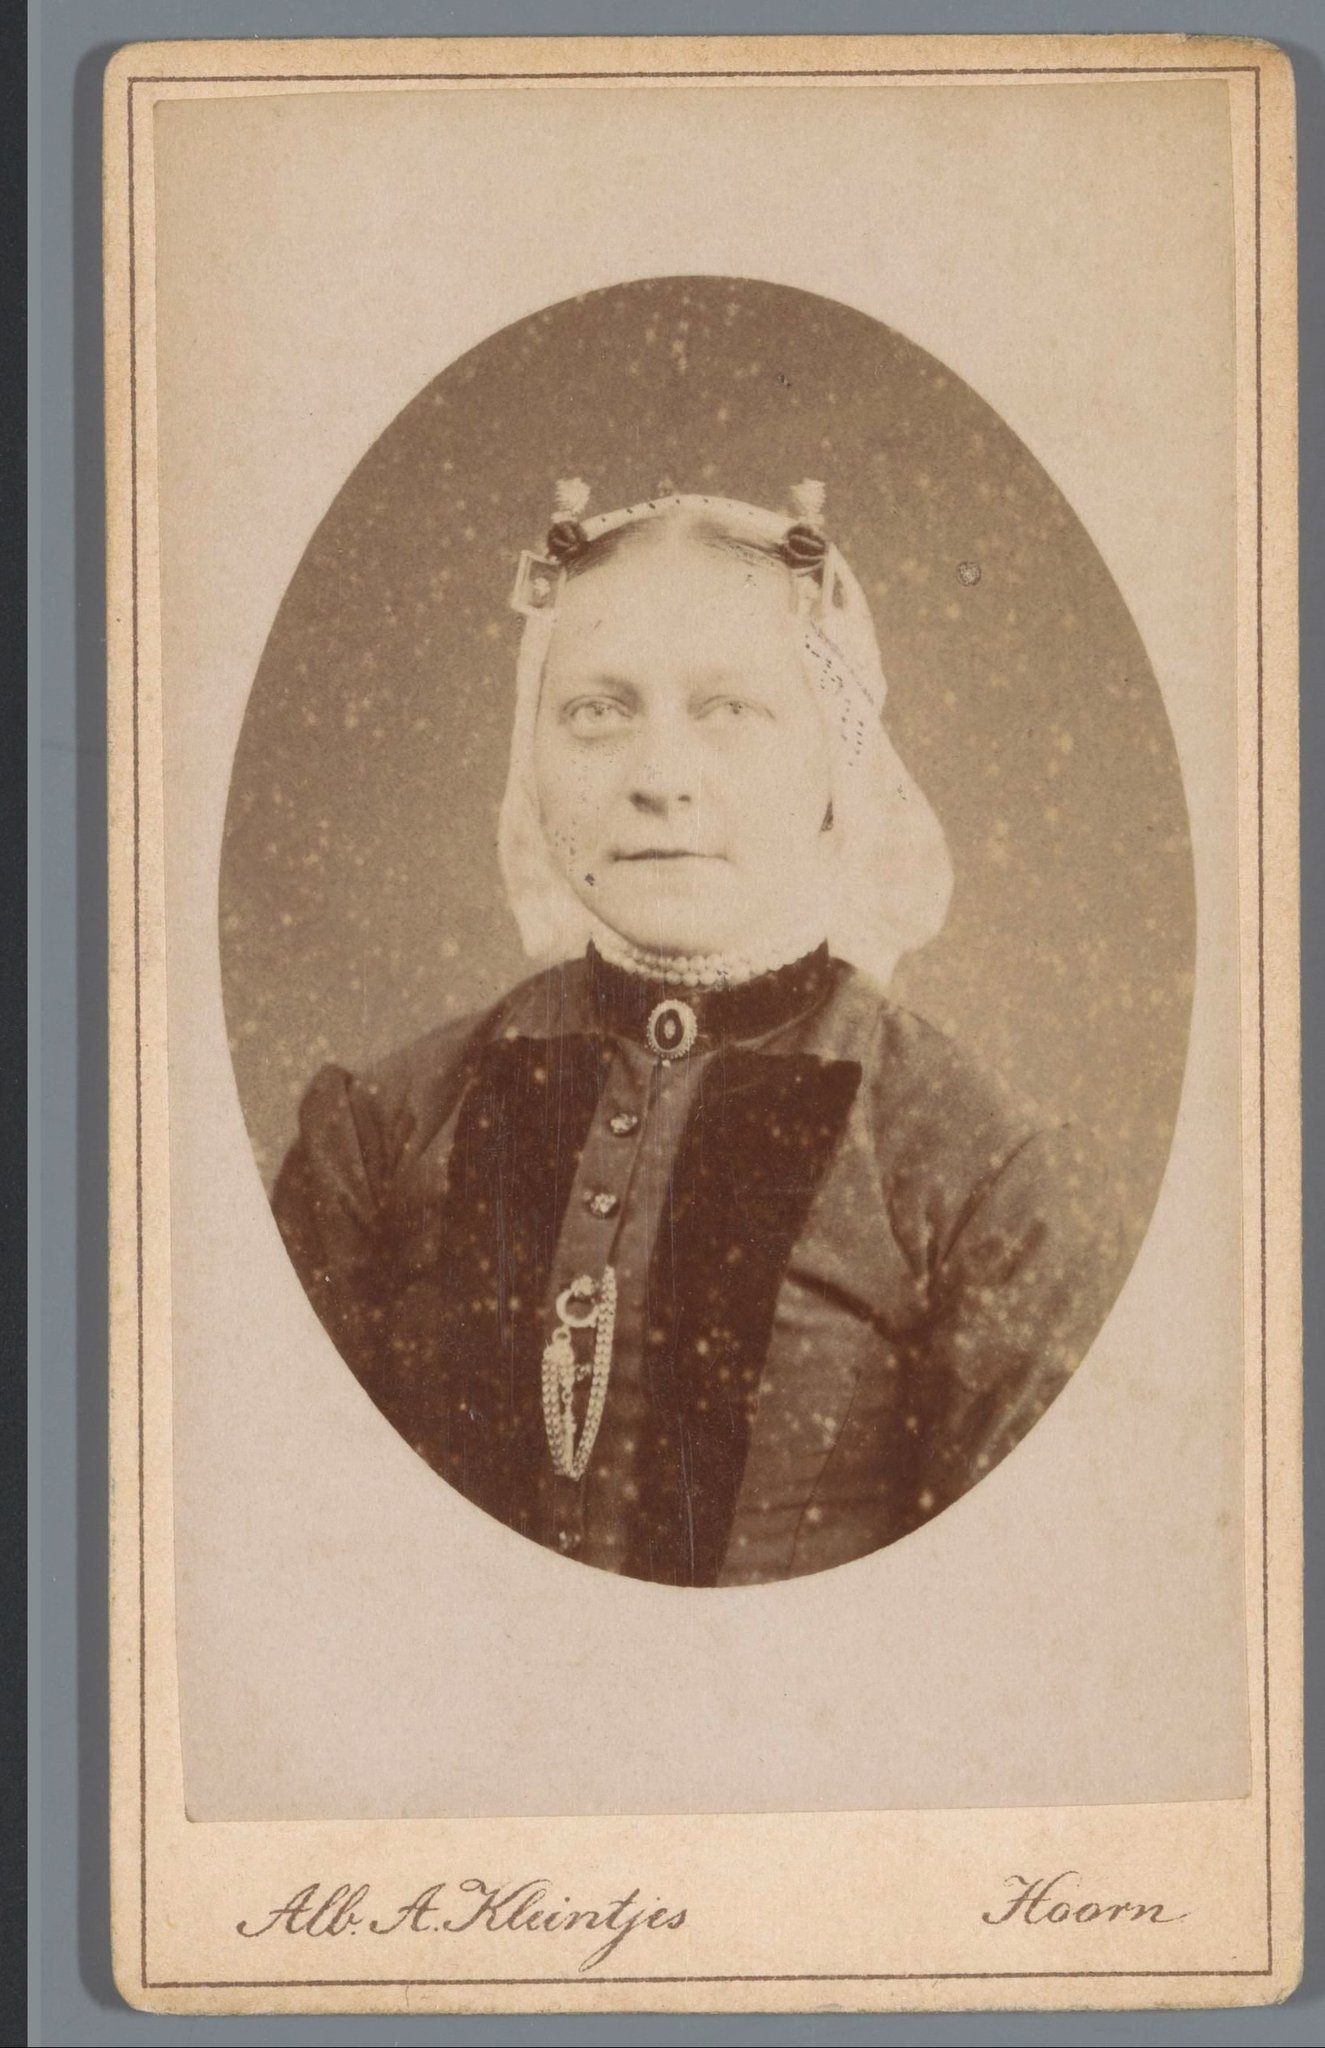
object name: photograph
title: Portret van Grietje Wester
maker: albert a. kleintjes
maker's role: fotograaf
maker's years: 1854-1942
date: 1893-1900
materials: cardboard, paper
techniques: albumen print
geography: hoorn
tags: historical persons - bb - woman, head-gear: cap, folk costume, regional costume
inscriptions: inscription: ‘Grietje Wester’, inscription: ‘Alb. A. Kleintjes/ Photographe/ Hoorn/ Kerkstraat/ 4e huis v. d. Kaasmarkt/ Nabestellingen en Vergrootingen van deze en andere/ Portretten kunnen ten allen tijde geleverd worden.’